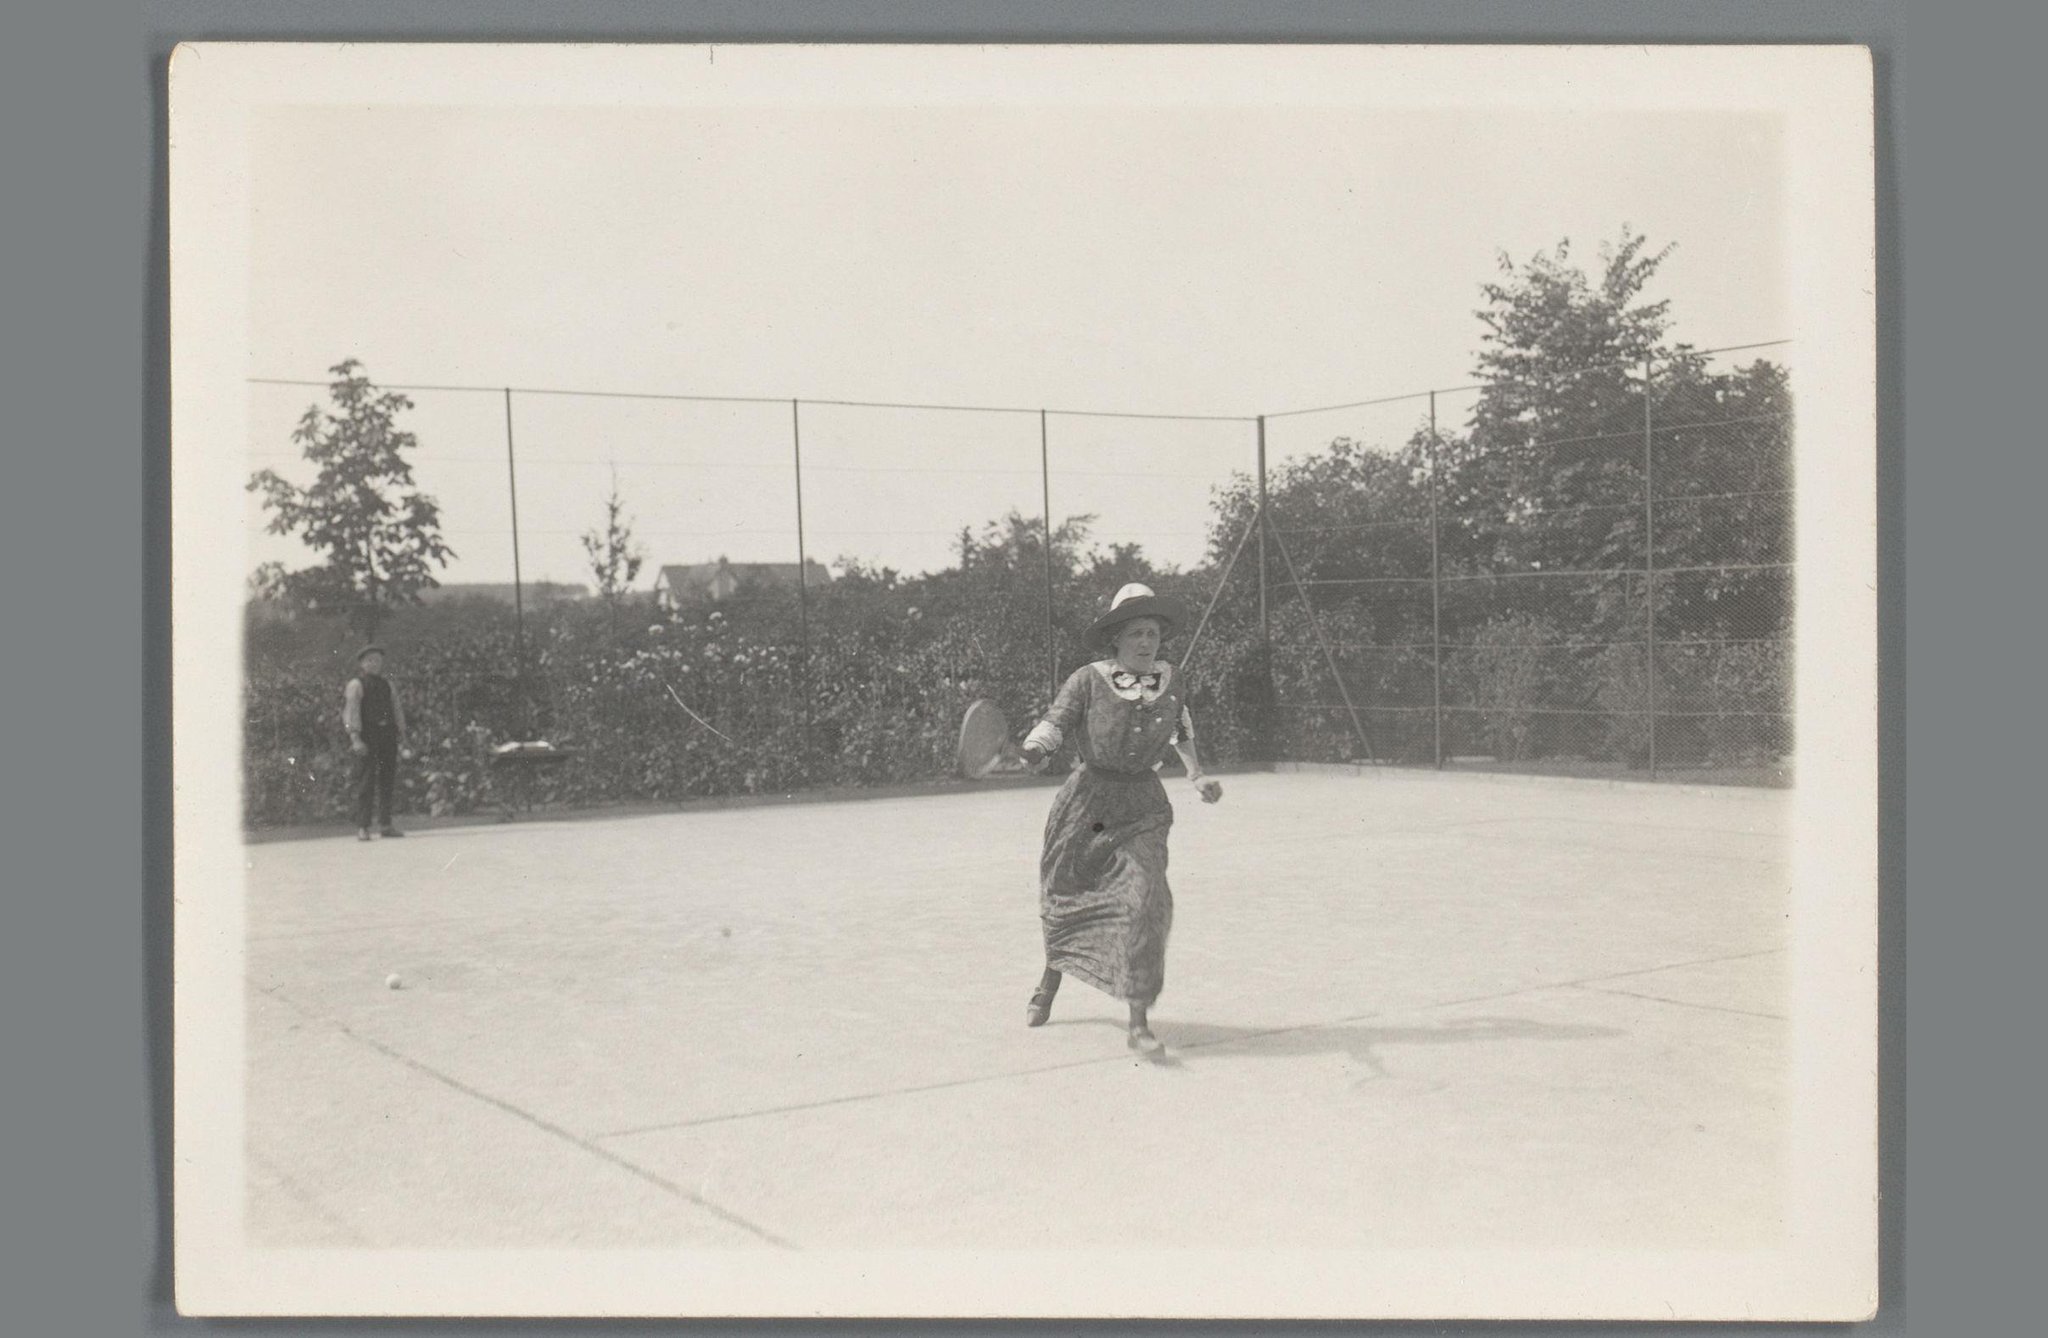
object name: photograph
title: Tennissende vrouw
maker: Anonymous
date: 1900-1920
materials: paper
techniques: gelatin silver print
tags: tennis, lawn-tennis, adult woman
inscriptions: number: ‘70’